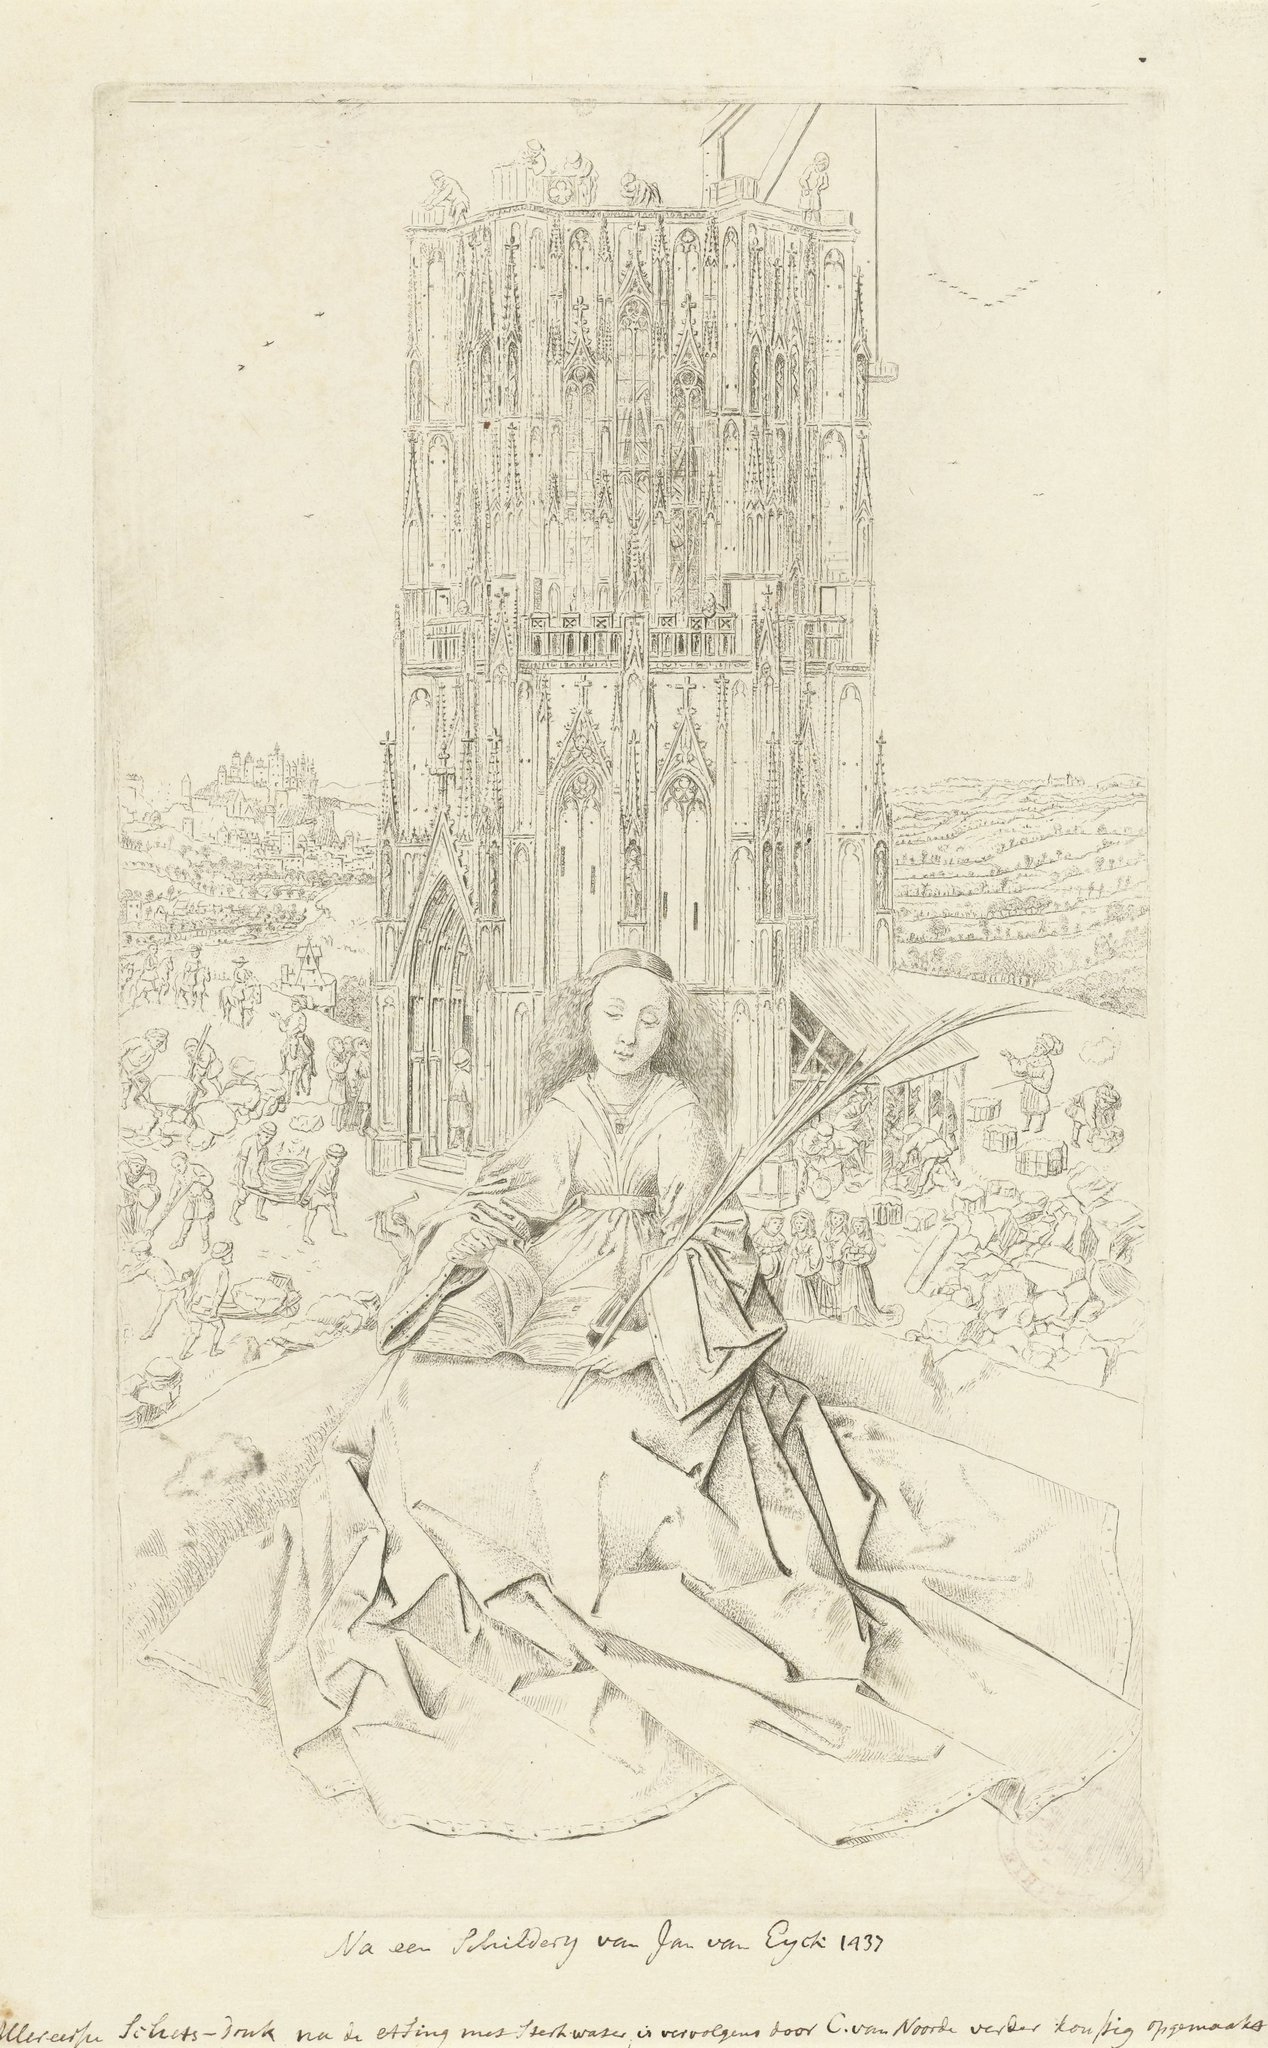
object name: print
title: Heilige Barbara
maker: cornelis van noorde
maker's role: draughtsman, print maker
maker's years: 1731-1795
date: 1741-1795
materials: paper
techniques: etching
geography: haarlem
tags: the virgin martyr barbara; possible attributes: book, cannon(ball), crown, cross, chalice with wafer, dioscuros (her father), peacock feather, sword, torches, mason's tools, tower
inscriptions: collector's mark: Lugt 240, inscription: ‘Na een schilderij van Jan van Eyck 1437 / Allereerste schets-druk na de etsing met sterk water is vervolgend door C. van Noorde verder konstig opgemaakt’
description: De heilige Barbara, zittend, van voren gezien, met palmtak in de linkerhand en gebedenboek op schoot. Achter haar de bouw van de toren van een kathedraal. Prent naar het schilderij van Jan van Eyck. De voorstelling is opgeplakt op een apart blad met de geëtste lijst. Onder op de lijst het signatuur van Jan van Eyck en het jaartal 1437.